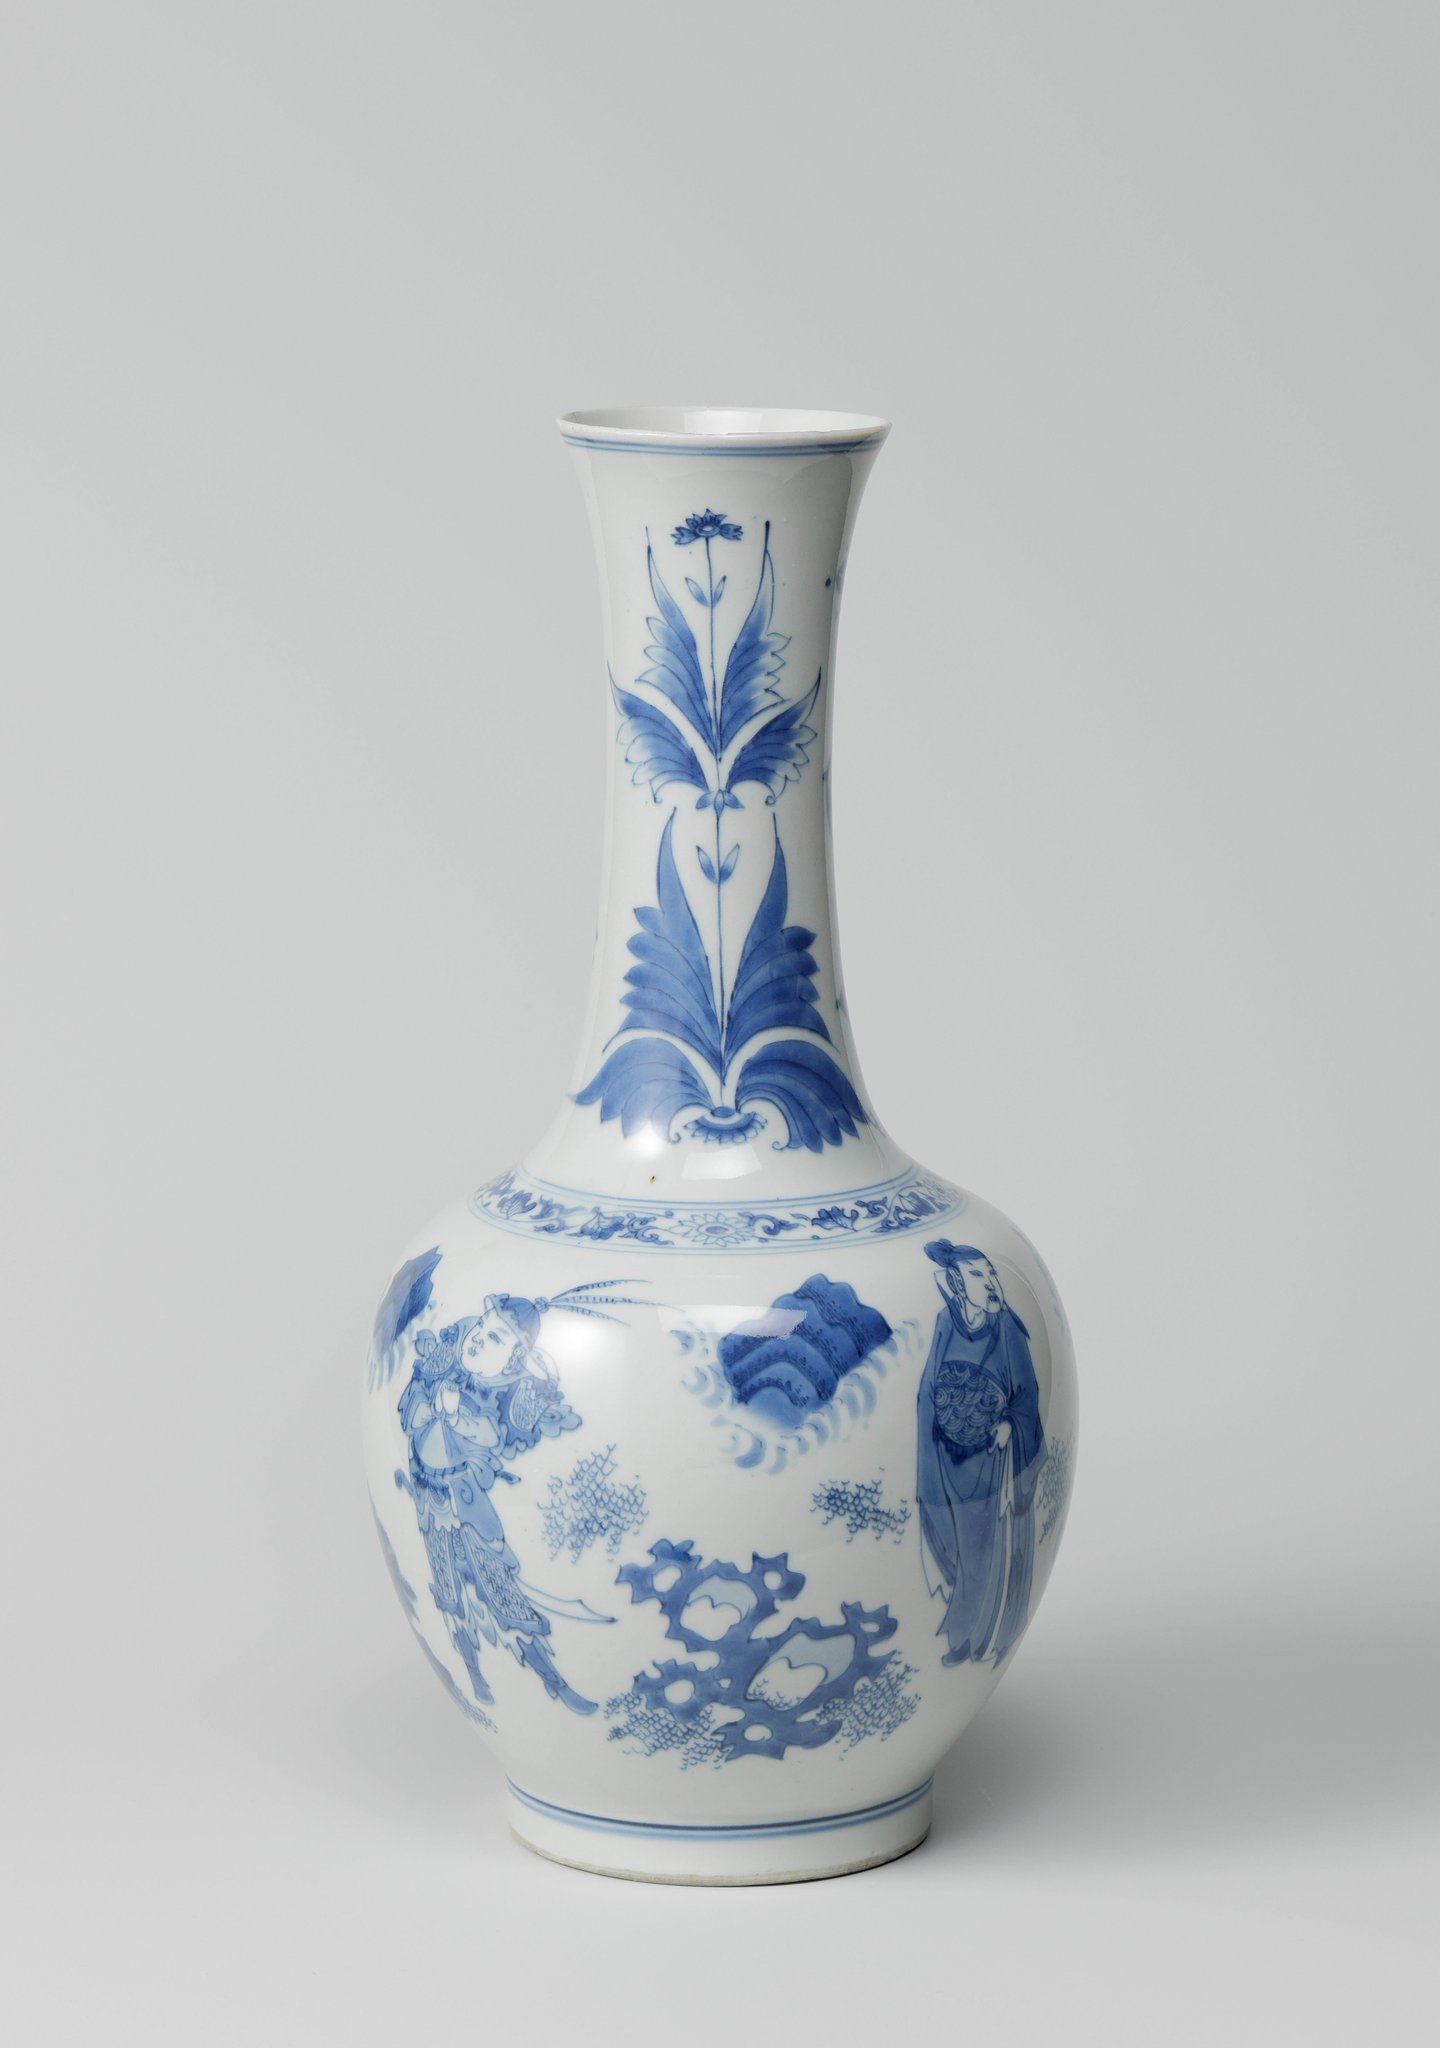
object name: vase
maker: Anonymous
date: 1635-1650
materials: cobalt, glaze, paint, porcelain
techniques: firing, turning, vitrification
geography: china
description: AK-NM-6688 Twee vaszen • Overgangsporselein • Onderdeel van Royers porseleincollectie • Mogelijk onderdeel van Huygens’ porseleincollectie • Met dank aan Fan Lin, Qinxin He and Erika Riccobon, Universiteit Leiden, voor informatie over de voorstelling Vazen met deze vorm en beschilderd met vier grote figuren op de buik zijn ook in andere collecties bekend – vaak als paar. Het kunnen samen de Acht Onsterfelijken voorstellen [Butler 1990, nr. 40), in een ander geval zijn figuren uit het verhaal Water Margin herkend [Canepa 2019, nr. 103]. In dit geval zijn het zeker niet de Onsterfelijken, maar of het Water Margin-personages zijn is niet met zekerheid te zeggen. AK-NM-6688-A bevat militairen, met een vlag met daarop het karakter ling (bevel), een ander met een hellebaaard, mogelijk Lu Bu, een generaal uit de Han-dynastie of Xue Rengui, een generaal uit de Tang-dynastie. Op AK-NM-6688-B zijn afwisselend militairen en ambtelijke hoogwaardigheidsbekleders geschilderd. Het zijn in ieder geval personages uit populaire toneelstukken en romans waarvan de afbeeldingen in houtsnede als voorbeeld hebben gediend. Literatuur, boekprductie en houtsnede-illustraties bloeiden hoog op in de periode dat dit porselein werd beschilderd. Opvallend zijn weer te grote (niet-Chinese) bloemmotieven op de hals die in verband kunnen worden gebracht met de waarschuwing uit 1635 van de VOC bewindhebbers om porselein met dergelijke bloemen níet te sturen omdat ze er niet Chinees genoeg uitzagen. De figuren op deze vazen zijn (waarschijnlijk – we weten niet precies wie het zijn dus een voorbehoud is wel nodig) in oorsprong historische personen, maar wel sterk tot theaterpersonages getransformeerd. Royer had in zijn studiecollectie een album met dergelijke figuren – heel kleurrijk in waterverf (360-378-B). Helaas is er geen exacte parallel aan te wijzen tussen de figuren op de vazen en die in de albums. En bij zijn gedrukte boeken had hij een uitgave van Three Kingdoms met voorin in houtsnede paginagroot afbeeldingen van de hoofdpersonen – een latere navolging van de bloeiende boekillustratie-productie uit de vroege 17de eeuw. Het is niet gezegd dat Royer daarmee de decors op deze vazen kon determineren. Het geeft alleen aan dat – hoewel studiecollectie en porseleincollectie twee entiteiten waren – het porselein soms op dezelfde manier als de studieverzameling een visuele bron kon zijn voor Royer. Het is goed mogelijk dat Royer deze vazen kocht uit de Huygens nalatenschap. Volgens de boedelbeschrijving gemaakt na het overlijden van Royers oudtante Susanna Louise Huygens (1714-1785) waren daar ‘Twee groote flessen met wyde halzen, met groote Chineesche figuuren, bladeren en bloemwerk.’ Een beschrijving die goed met deze stukken overeenkomt, aan het begin van de rubriek ‘blauw porselein’ waar ook de andere grote Overgangsstukken beschreven staan. Het is bekend dat Royer voor een groot bedrag porselein uit deze boedel overnam. Bronnen: Michael Butler, Margaret Medley, Stephen Little, Seventeenth-century Chinese porcelain from the Butler family collection, Alexandria 1990. Teresa Canepa, Jingdezhen to the world: the Lurie collection of Chinese export porcelain from the late Ming dynasty, Londen 2019.